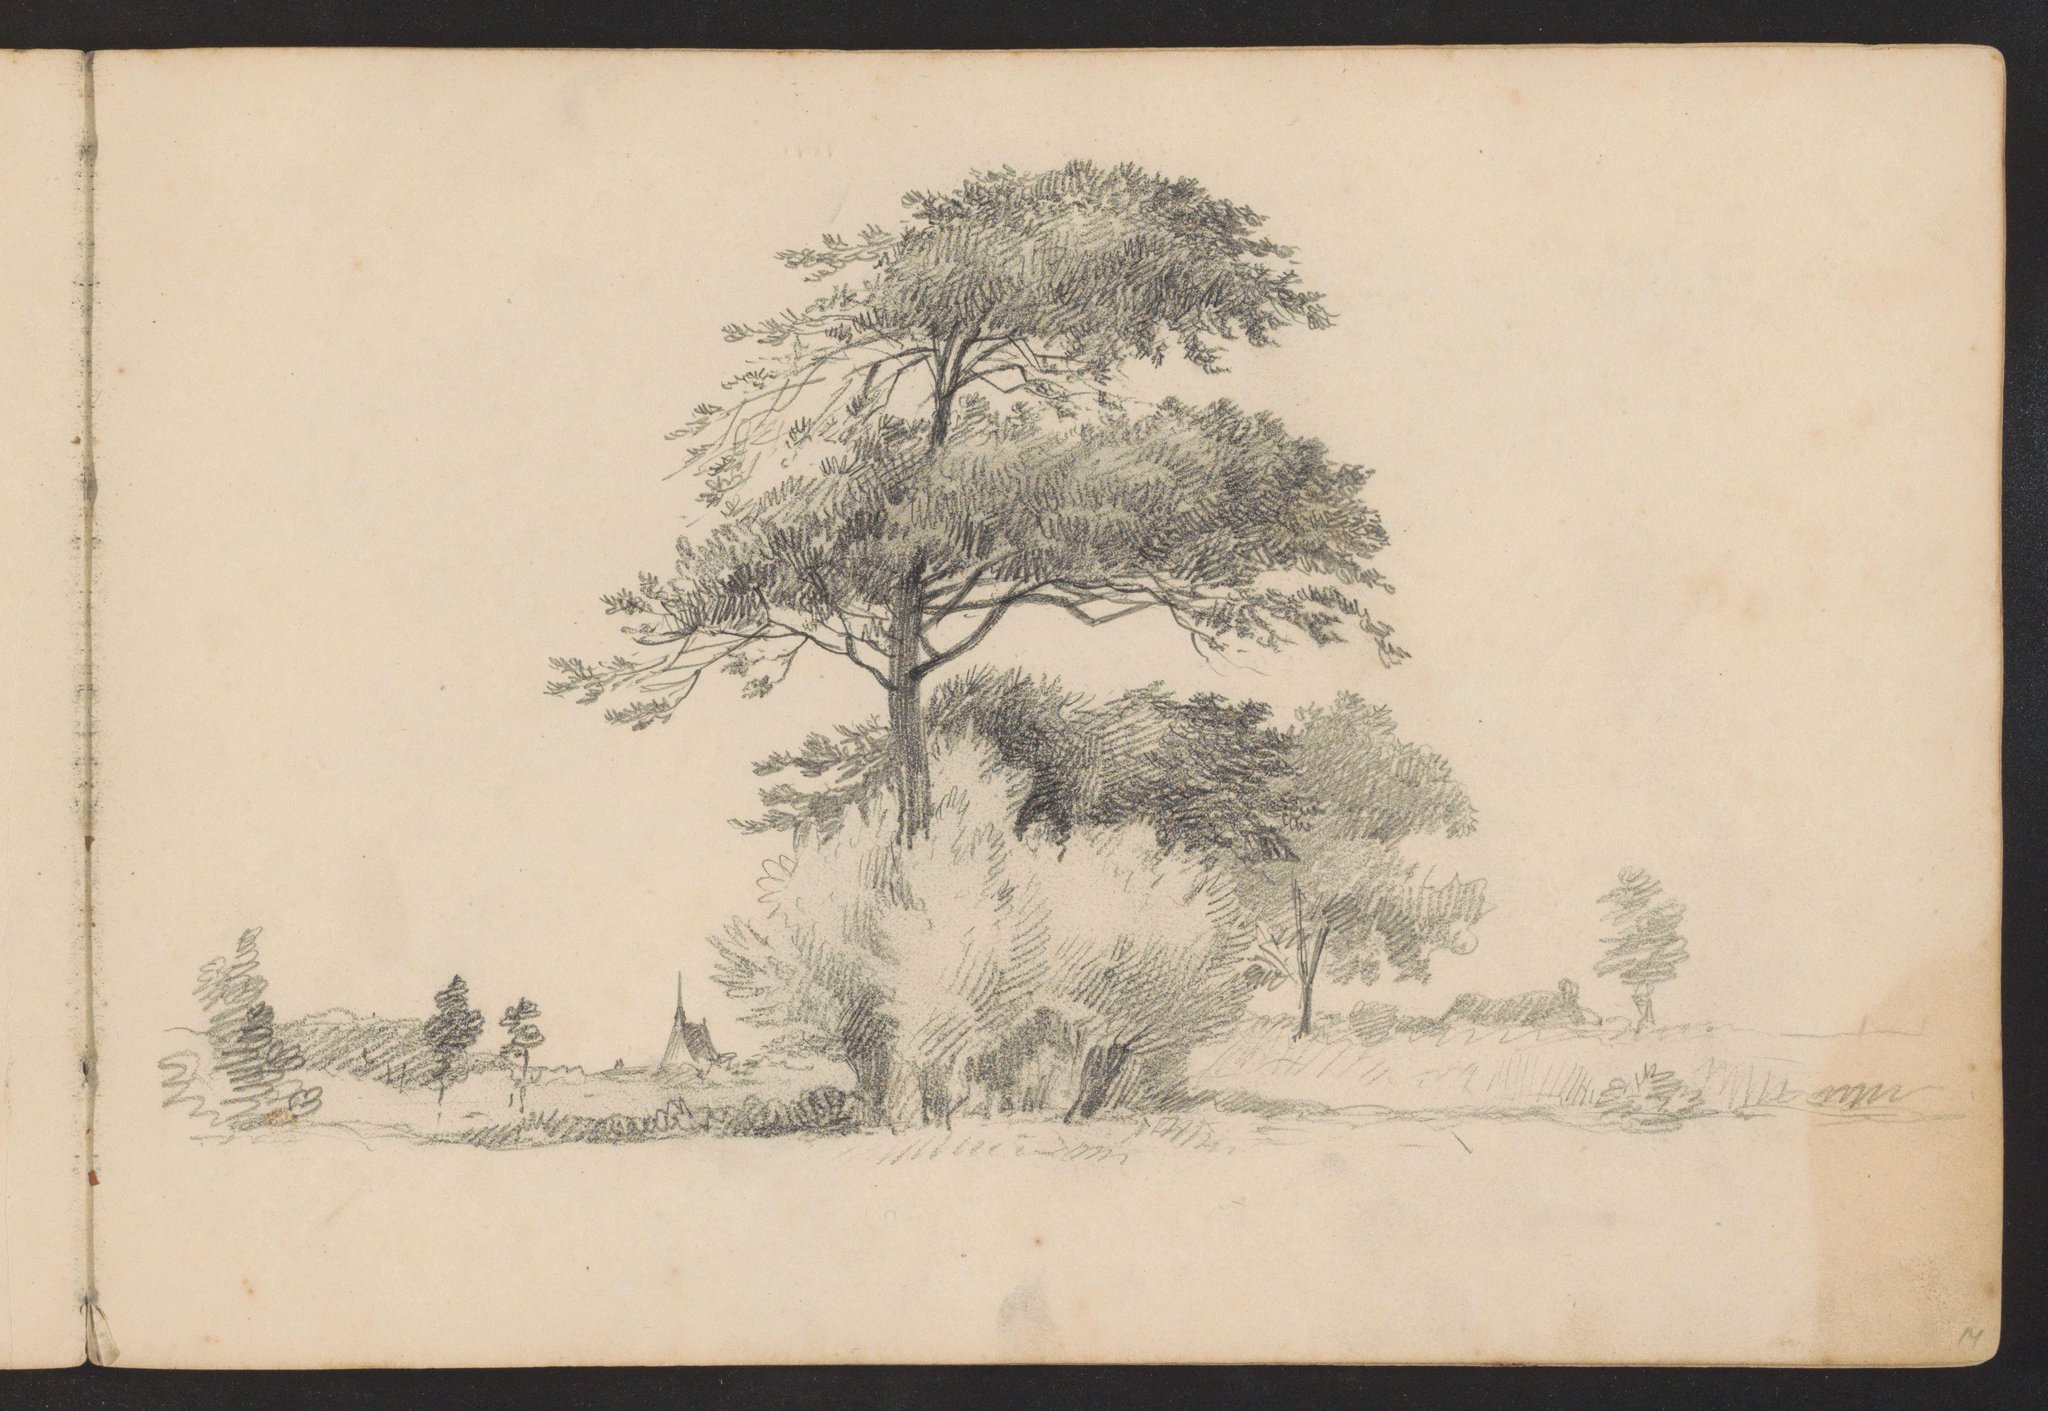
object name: sketchbook leaf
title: Vlak landschap met bomen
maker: johannes tavenraat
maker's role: draughtsman, painter, print maker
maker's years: 1809-1881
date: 1842-1868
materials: paper, pencil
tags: city-view, and landscape with man-made constructions, trees, spire (of tower on house or building)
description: Op de achtergrond een kerktoren. Blad 14 recto uit een schetsboek met 45 bladen.